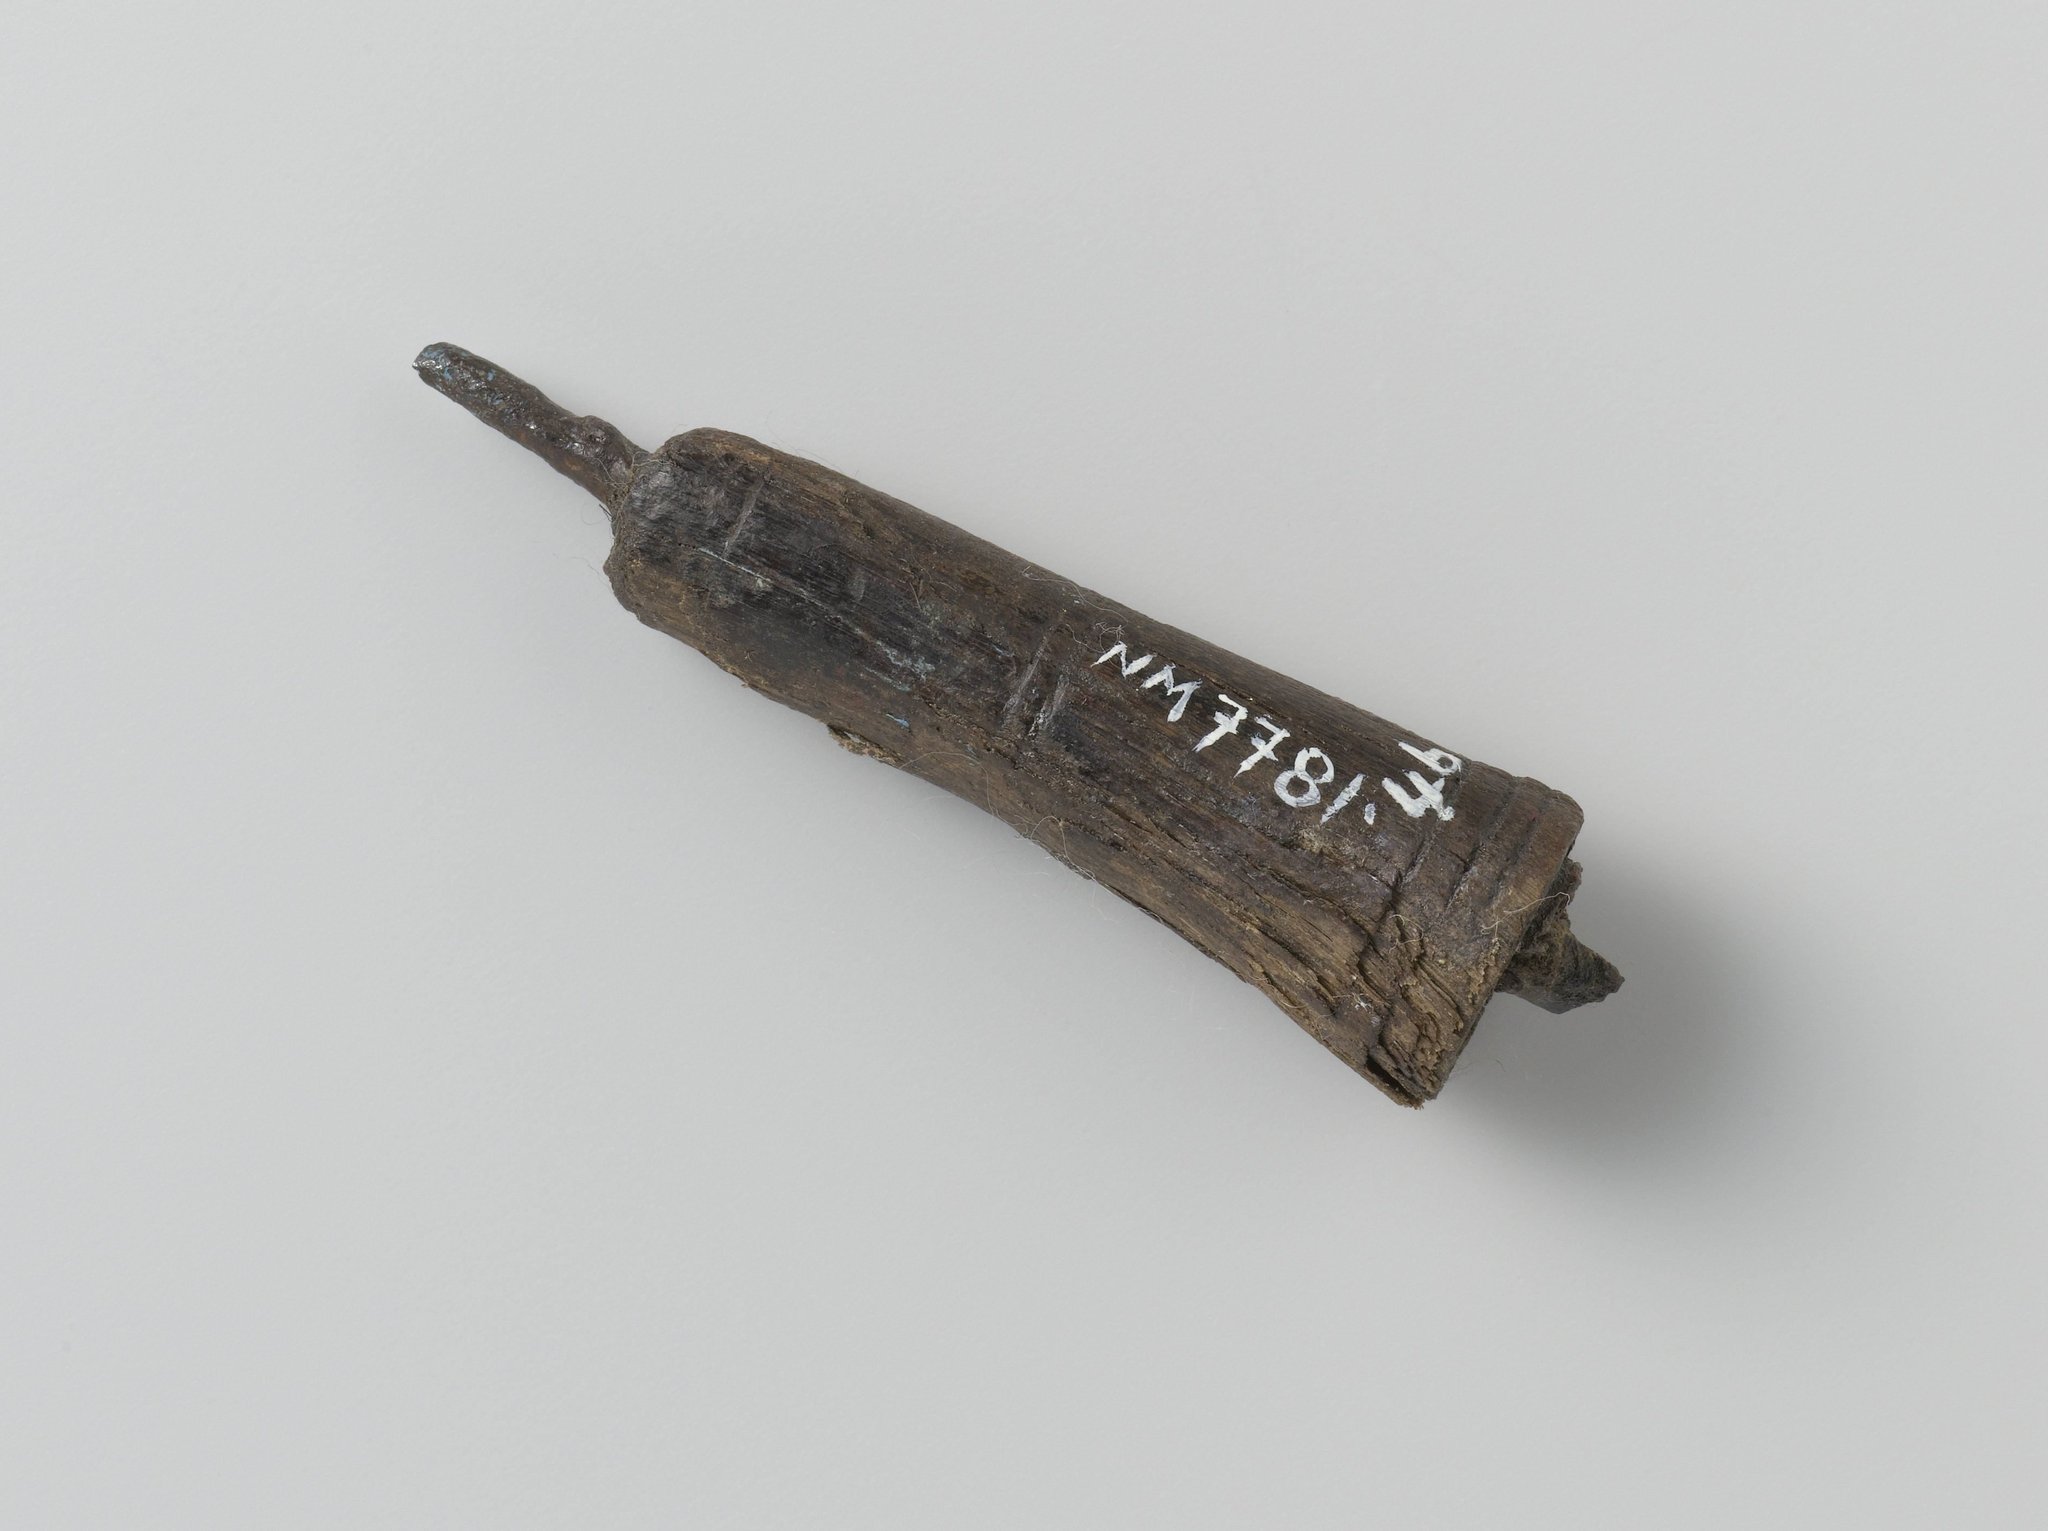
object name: awl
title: Priem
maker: Anonymous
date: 1590-1596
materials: iron, wood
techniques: cutting, forging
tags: willem barendsz., amsterdam, jacob van heemskerck